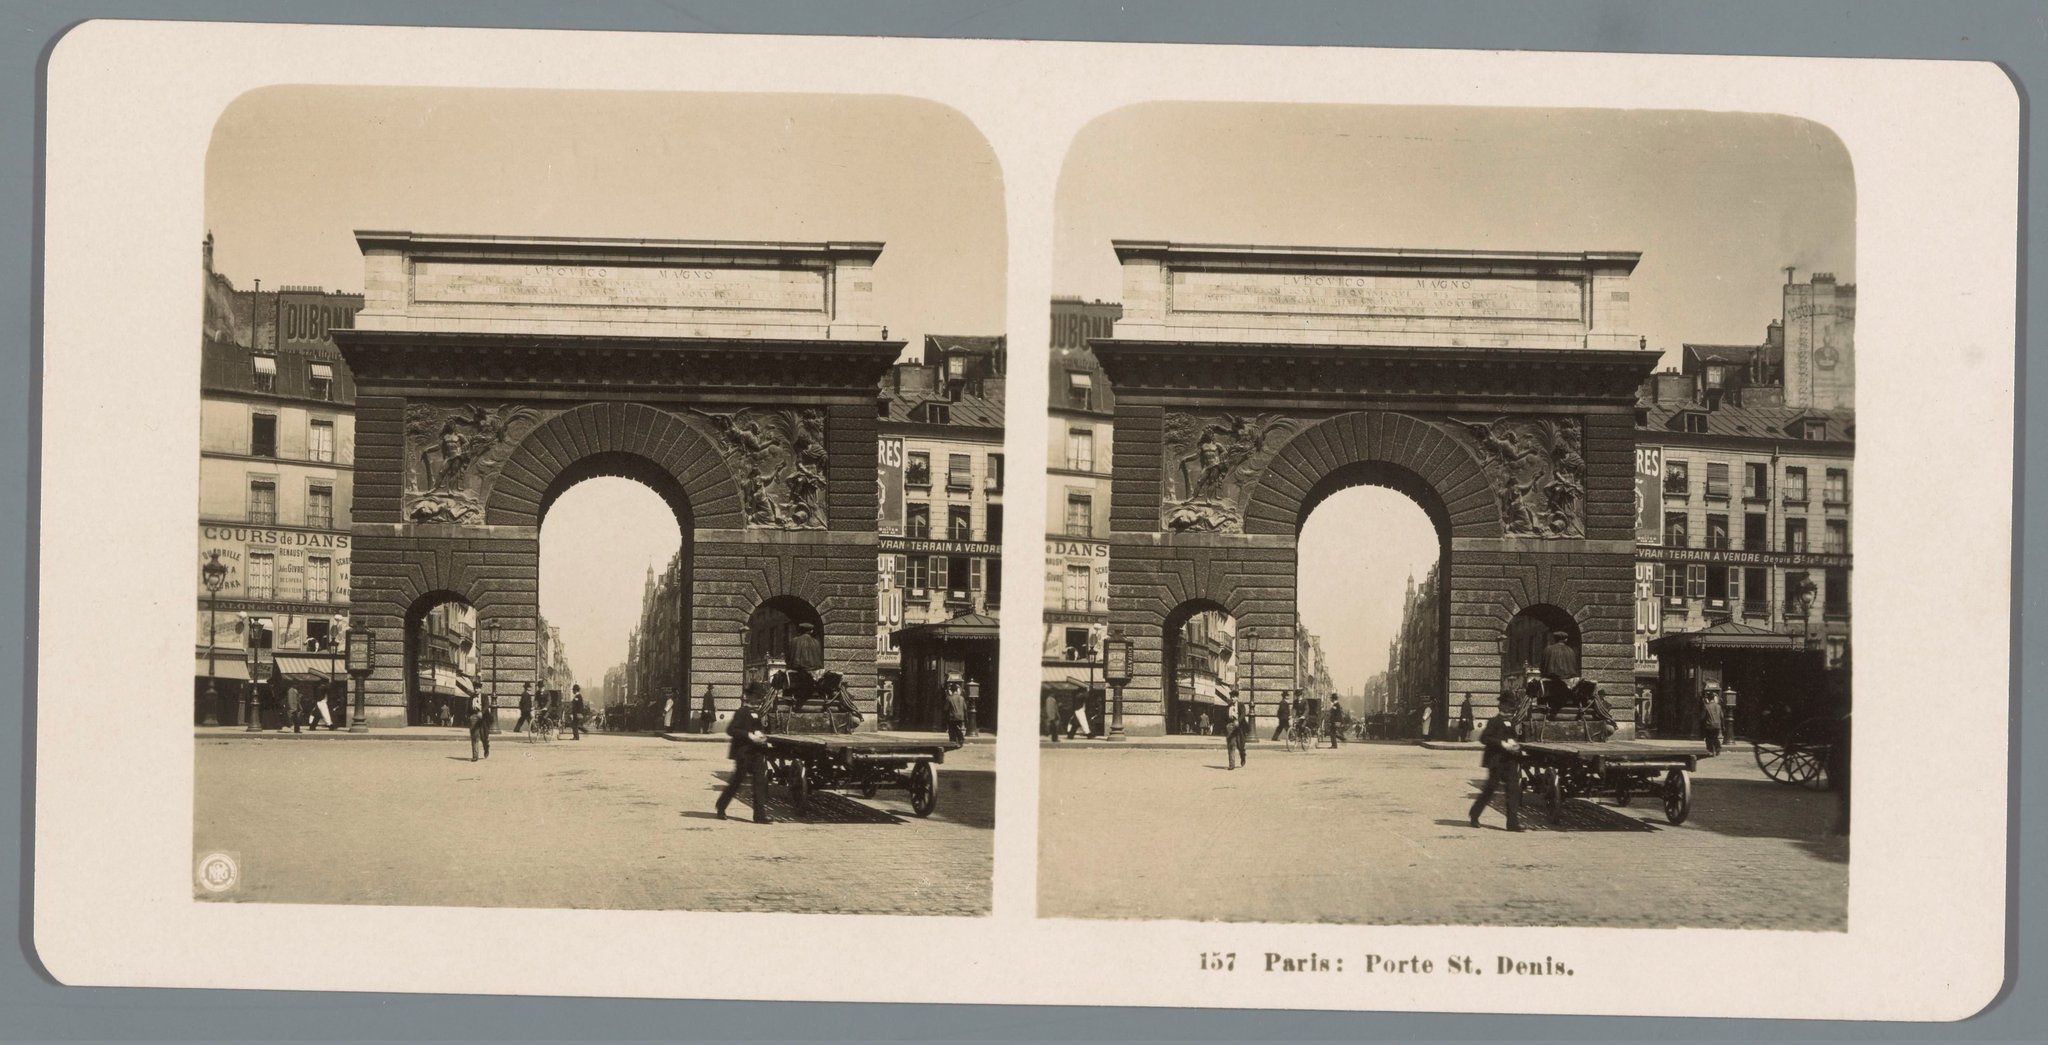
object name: stereograph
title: Gezicht op de Porte Saint-Denis te Parijs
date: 1895-1905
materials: cardboard, photographic support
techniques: gelatin silver print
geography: paris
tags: triumphal arch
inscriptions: inscription: ‘NPG’, number: ‘157’